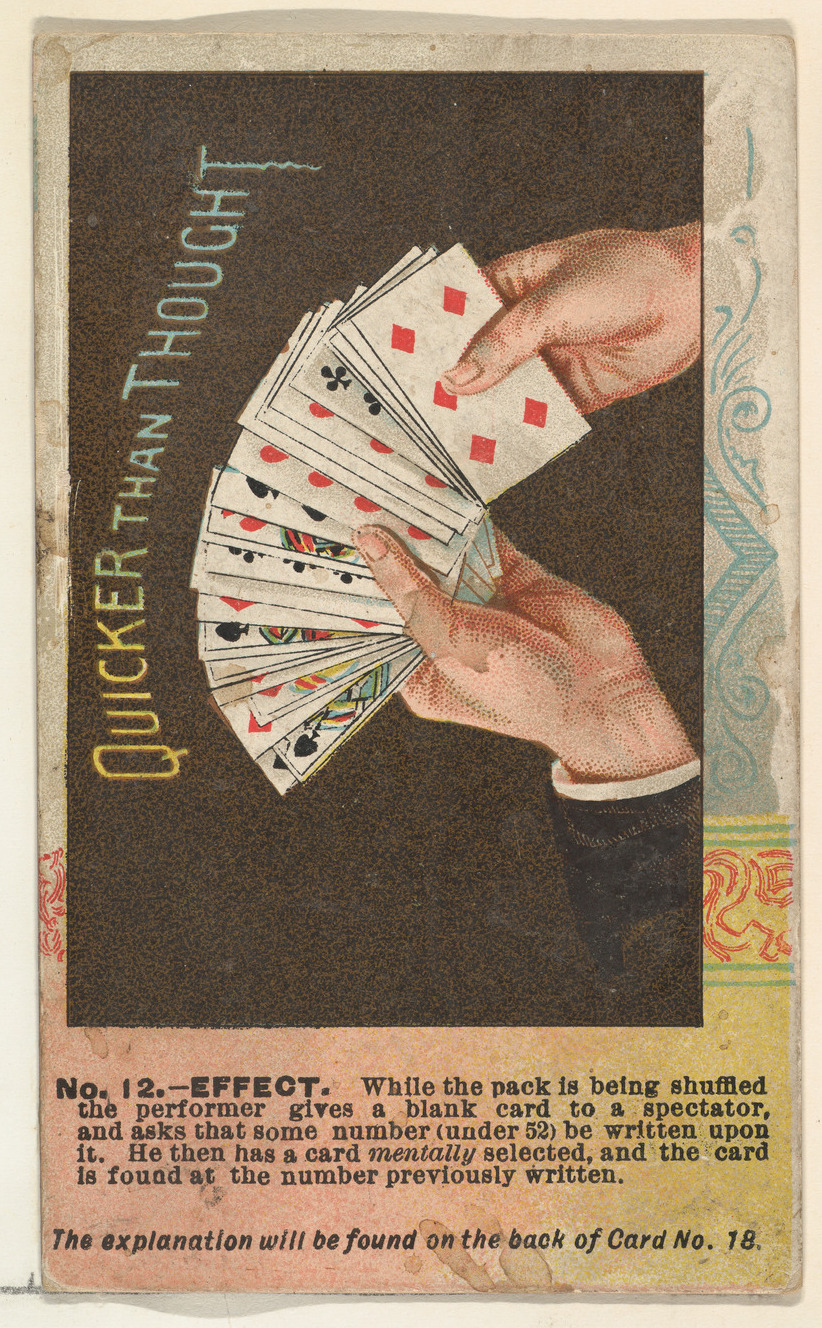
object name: print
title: Number 12, Quicker than Thought, from the Tricks with Cards series (N138) issued by W. Duke, Sons & Co. to promote Honest Long Cut Tobacco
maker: w. duke, sons & co.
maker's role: publisher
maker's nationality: american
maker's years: 1870-1920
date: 1887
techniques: color lithograph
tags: playing cards